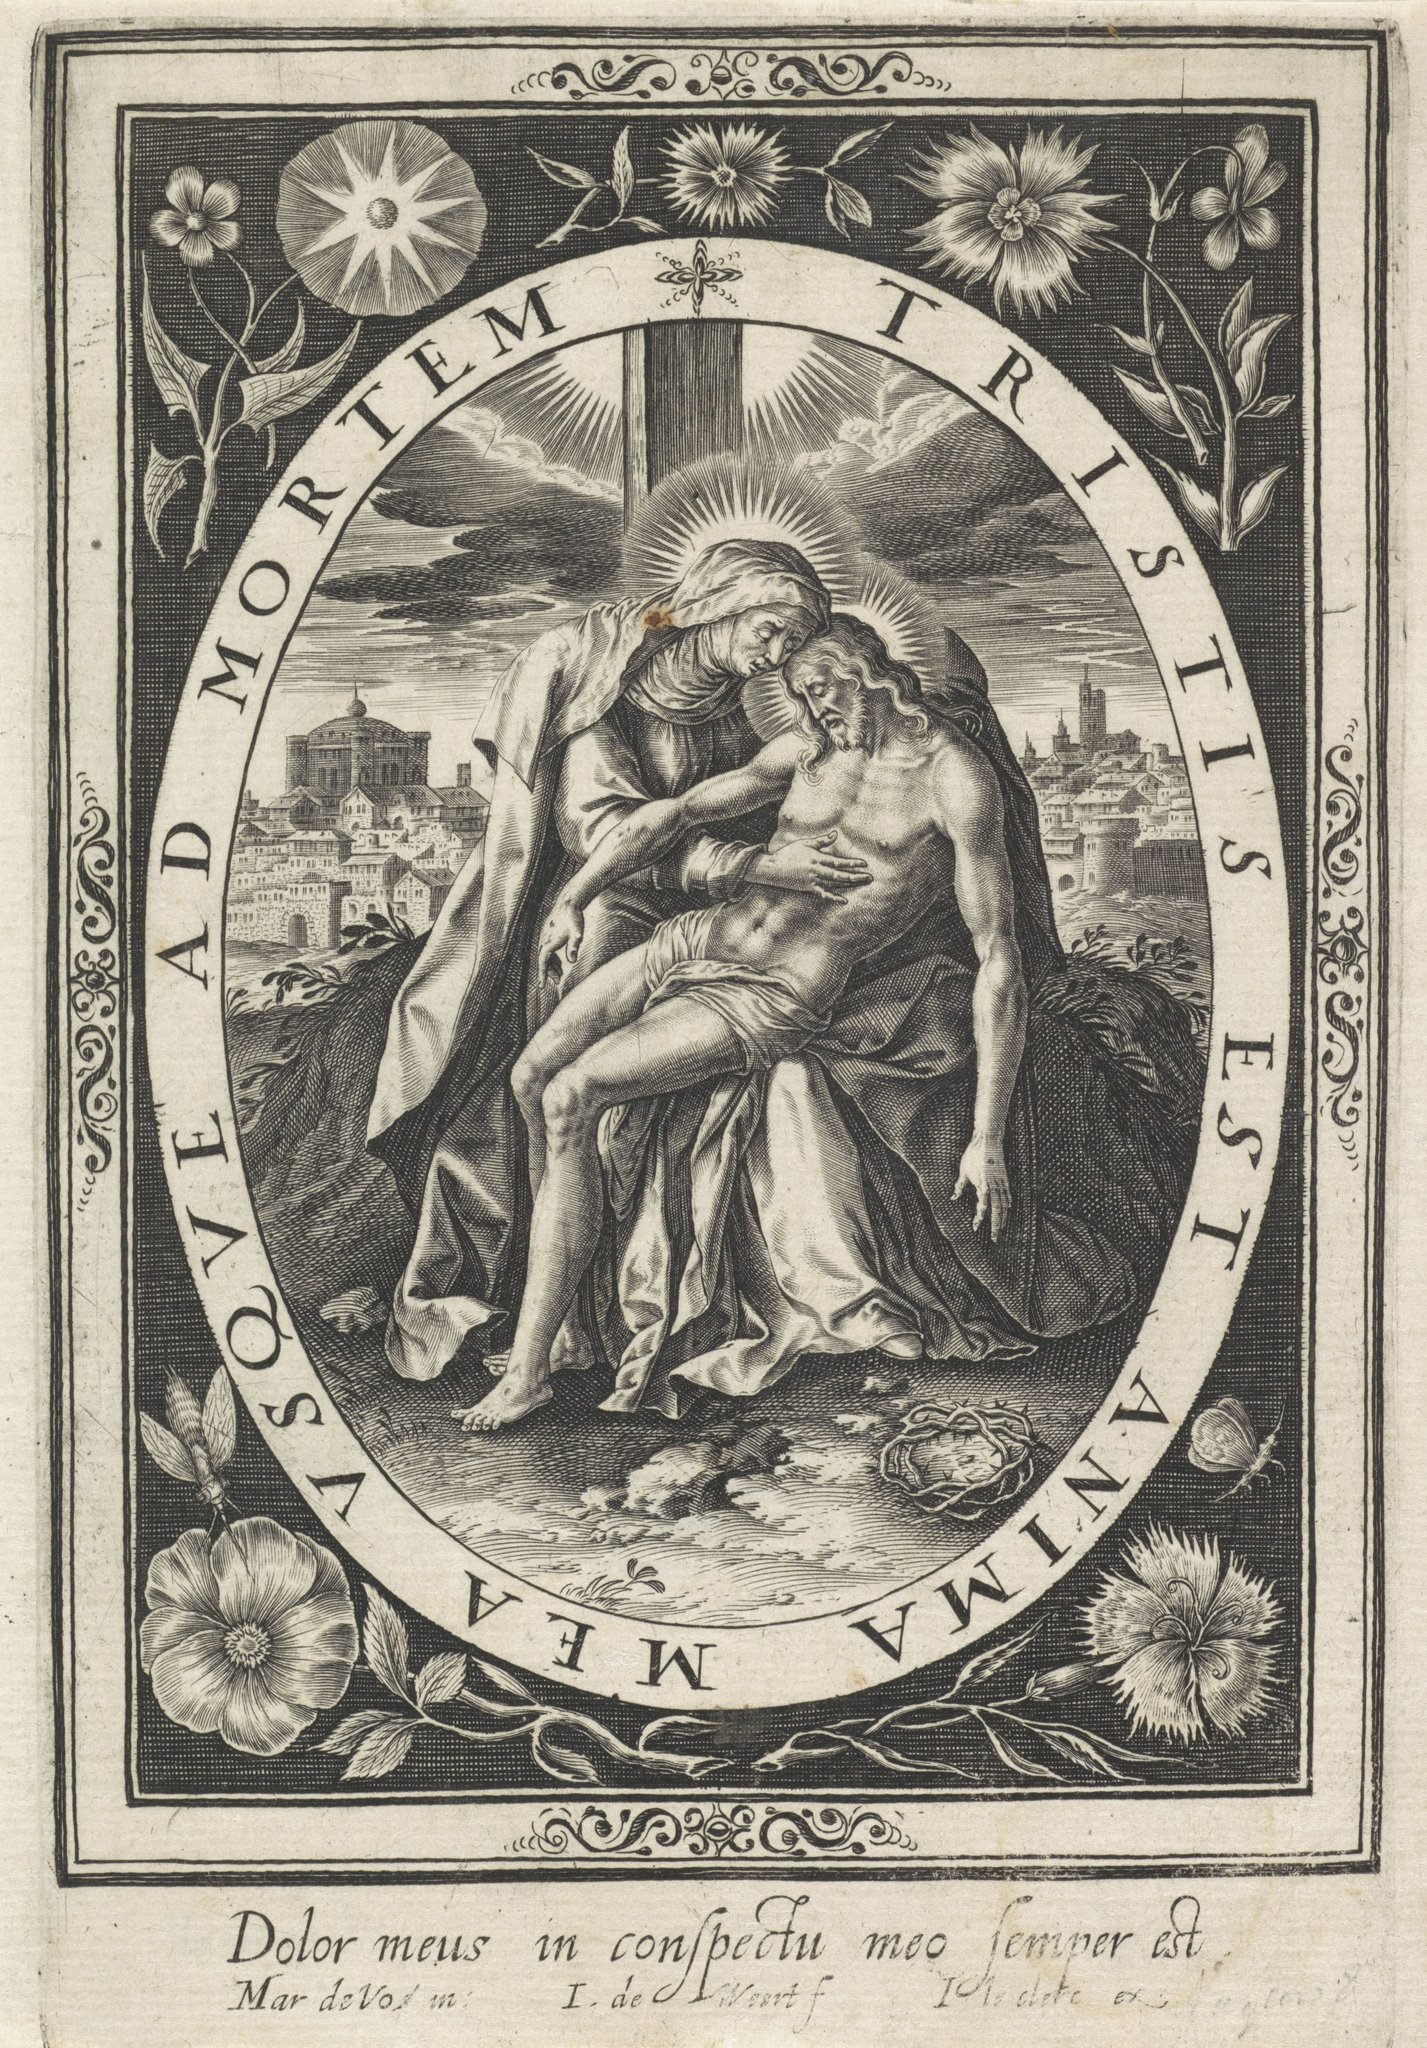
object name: print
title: Piëta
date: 1588-1621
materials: paper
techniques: engraving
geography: antwerp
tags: 'pietà ', 'vesperbild', 'marienklage' (no others present): christ, either with or without crown of thorns, mourned by mary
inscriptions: collector's mark: Lugt 2228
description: Voor het kruis beweent Maria het lichaam van de gestorven Christus, dat op haar schoot ligt. Voor hen ligt de doornenkroon op de grond. In de verte ligt Jeruzalem. De voorstelling wordt omgeven door een ovale rand met de Latijnse vertaling van 'Mijn ziel is ten dode bedroefd'. Buiten de ovale omlijsting zijn verschillende bloemen in een ornamentrand weergegeven, waaronder mogelijk passiebloemen. Onder de voorstelling bevindt zich nog een éénregelige, Latijnse tekst uit Psalm 38.